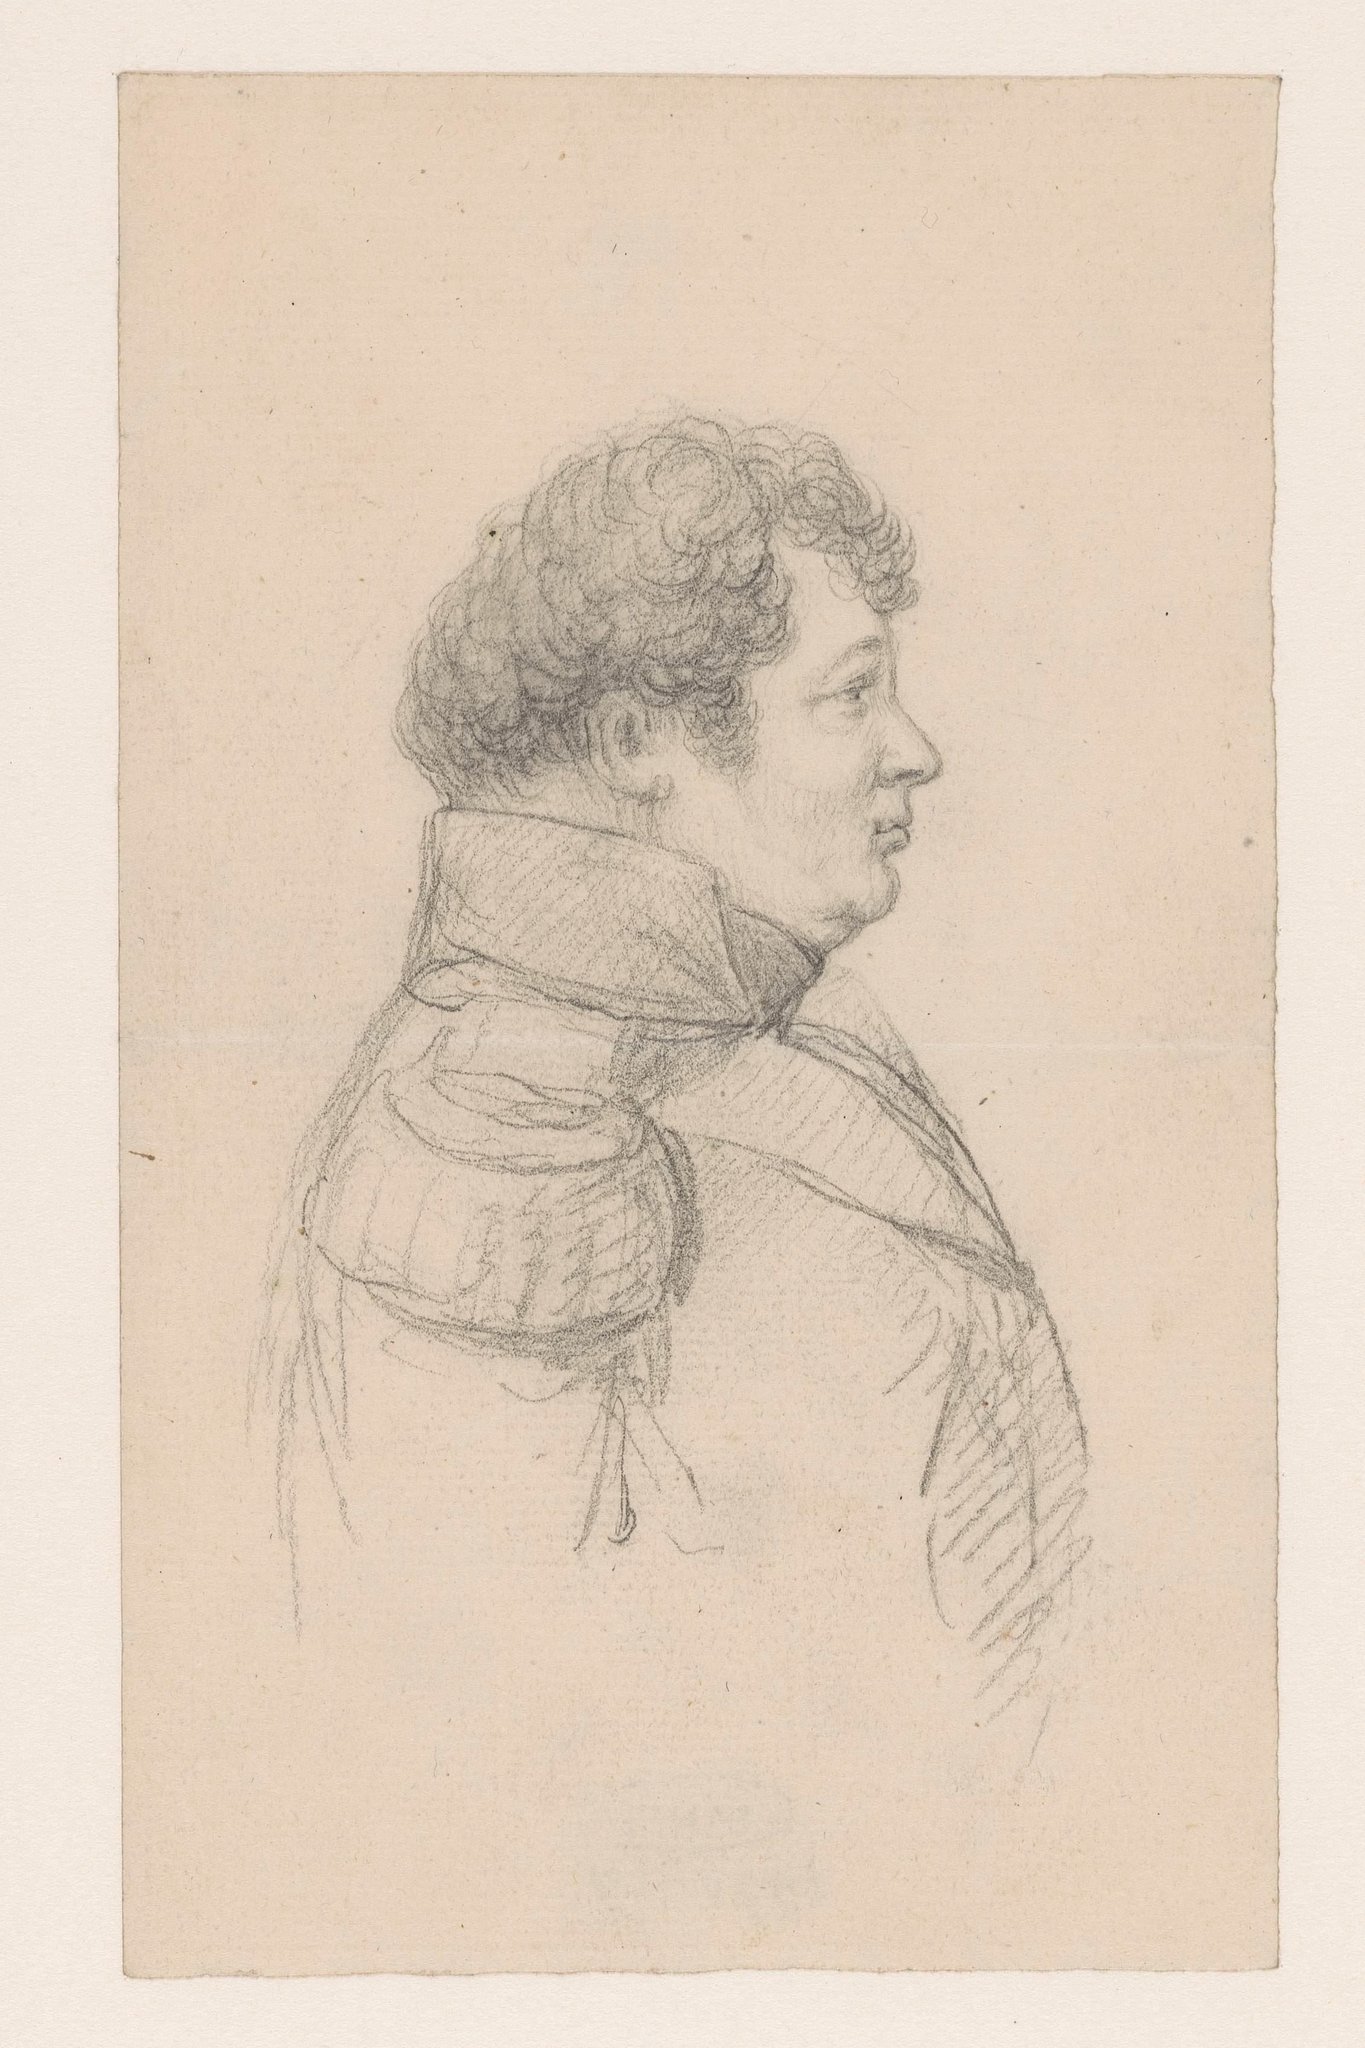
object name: drawing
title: Portret van een militair, in profiel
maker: christian heinrich gottlieb steuerwald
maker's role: draughtsman, print maker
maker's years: 1802-1874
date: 1822-1874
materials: paper, pencil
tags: anonymous historical person portrayed alone